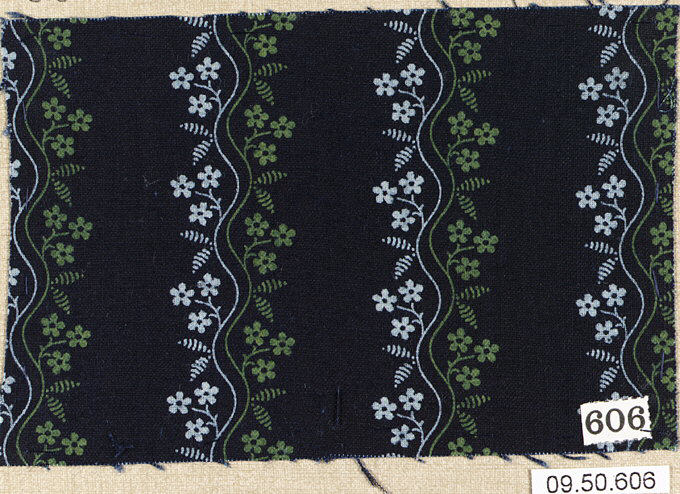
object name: piece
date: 1801-1900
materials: cotton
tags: flowers,leaves